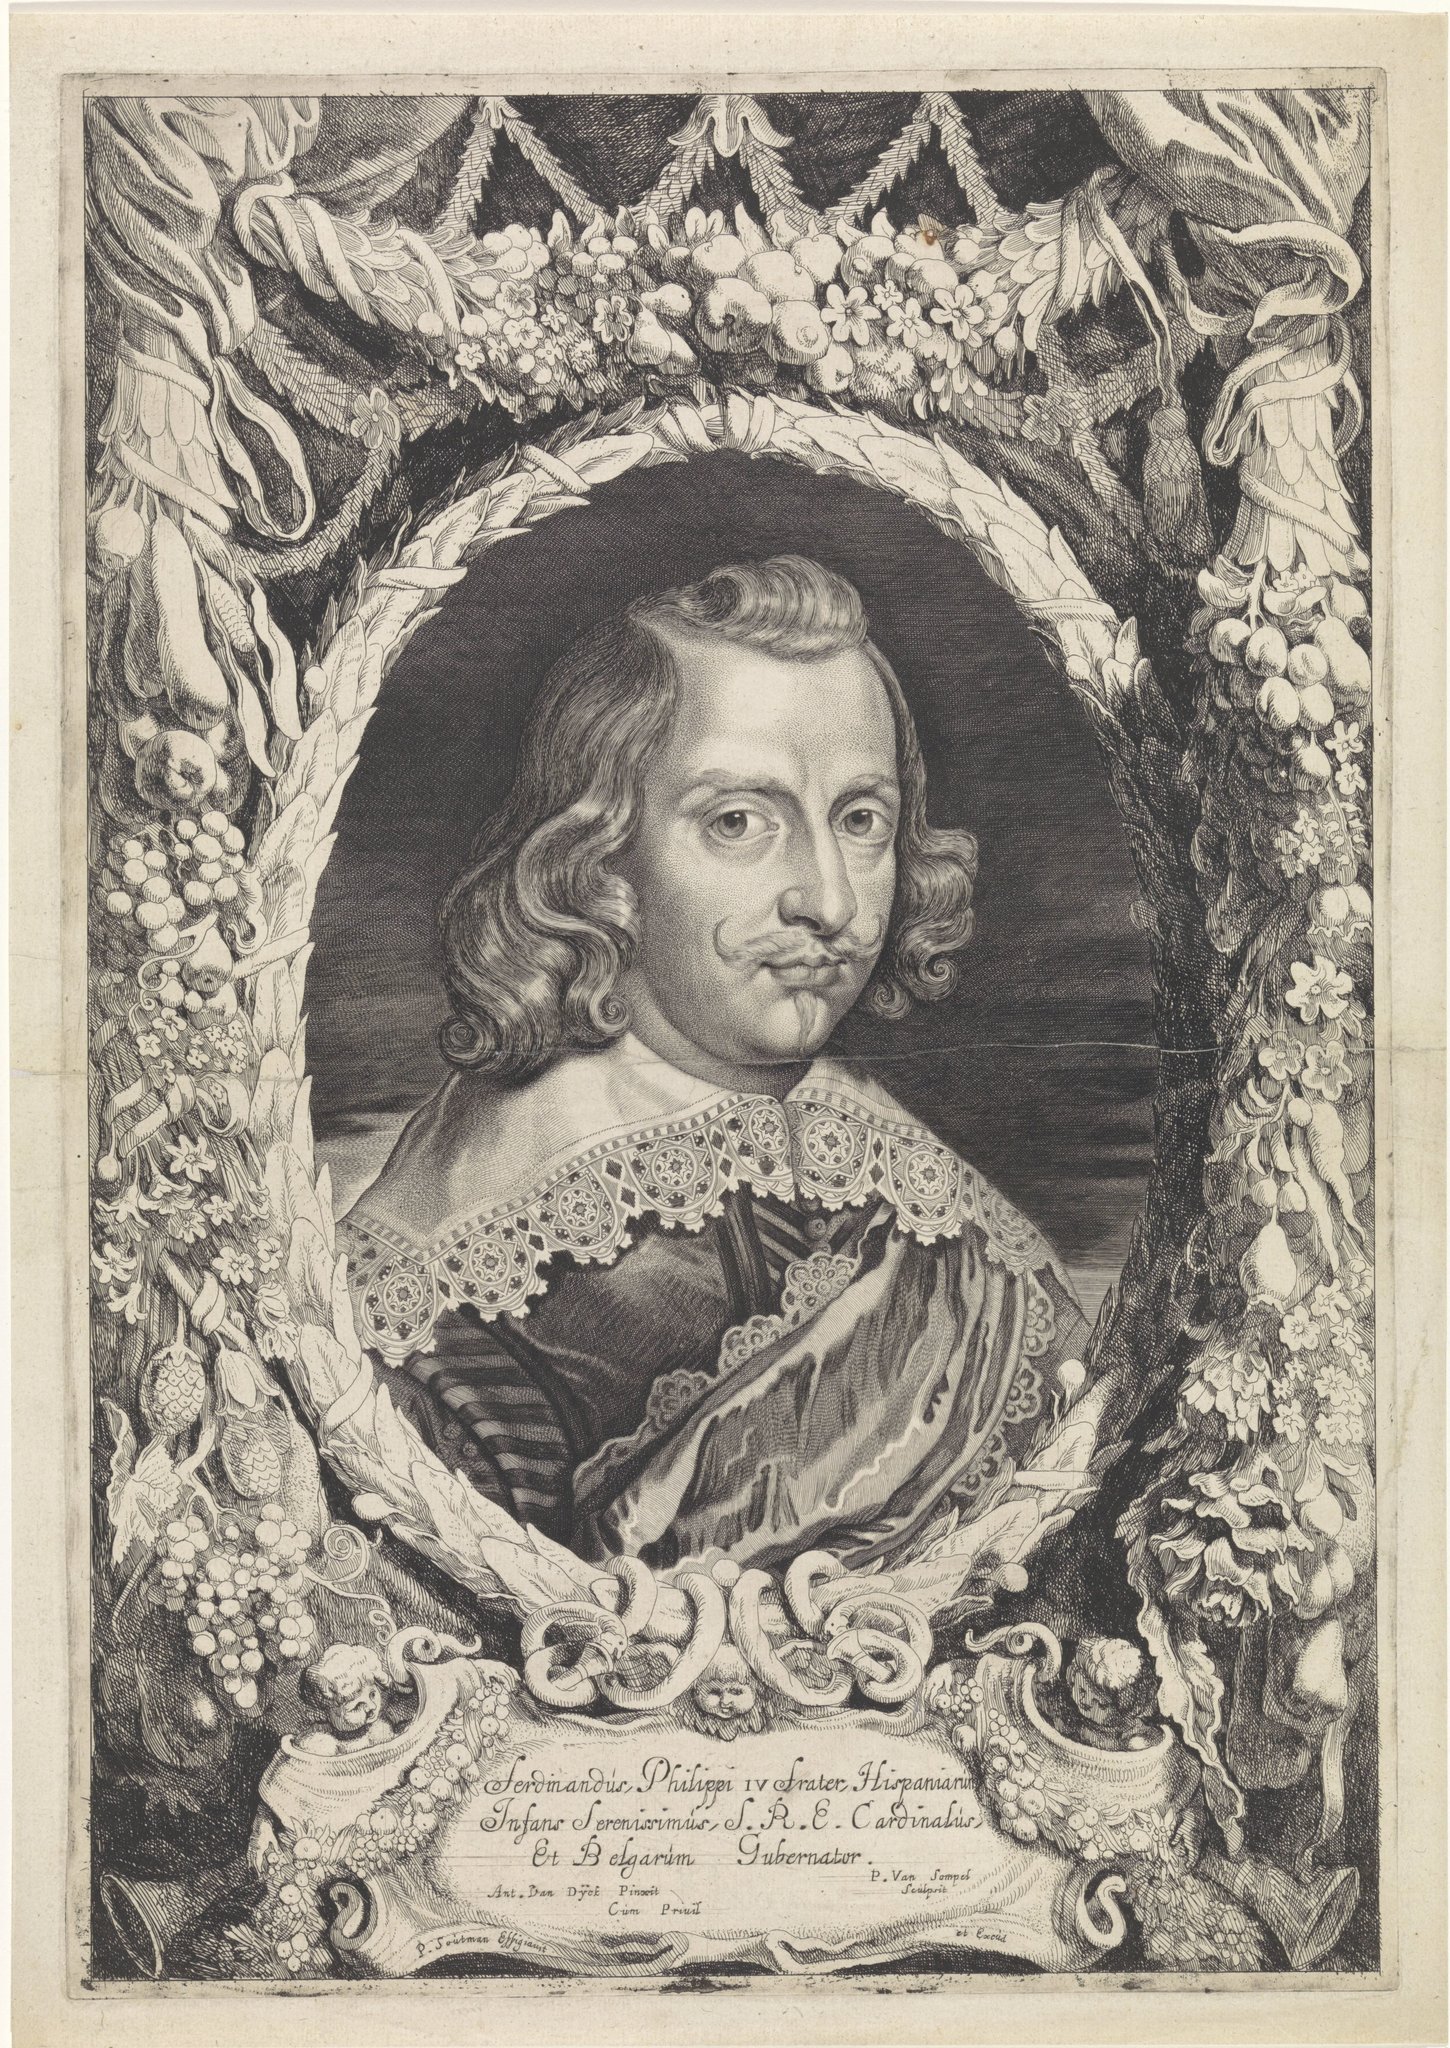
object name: print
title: Ferdinandus II[us] et III[us] Imperatorum Domus Austriacae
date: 1644-1650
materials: paper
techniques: engraving, etching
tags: landvoogd der zuidelijke nederlanden ferdinand van oostenrijk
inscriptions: collector's mark: Lugt 2233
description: Portret van Ferdinand van Oostenrijk, landvoogd der zuidelijke Nederlanden. Het portret wordt omlijst door guirlandes met vruchten. Onder het portret een cartouche met in het Latijn zijn naam, familirelatie tot de Spaanse koning Filips IV en zijn titels.